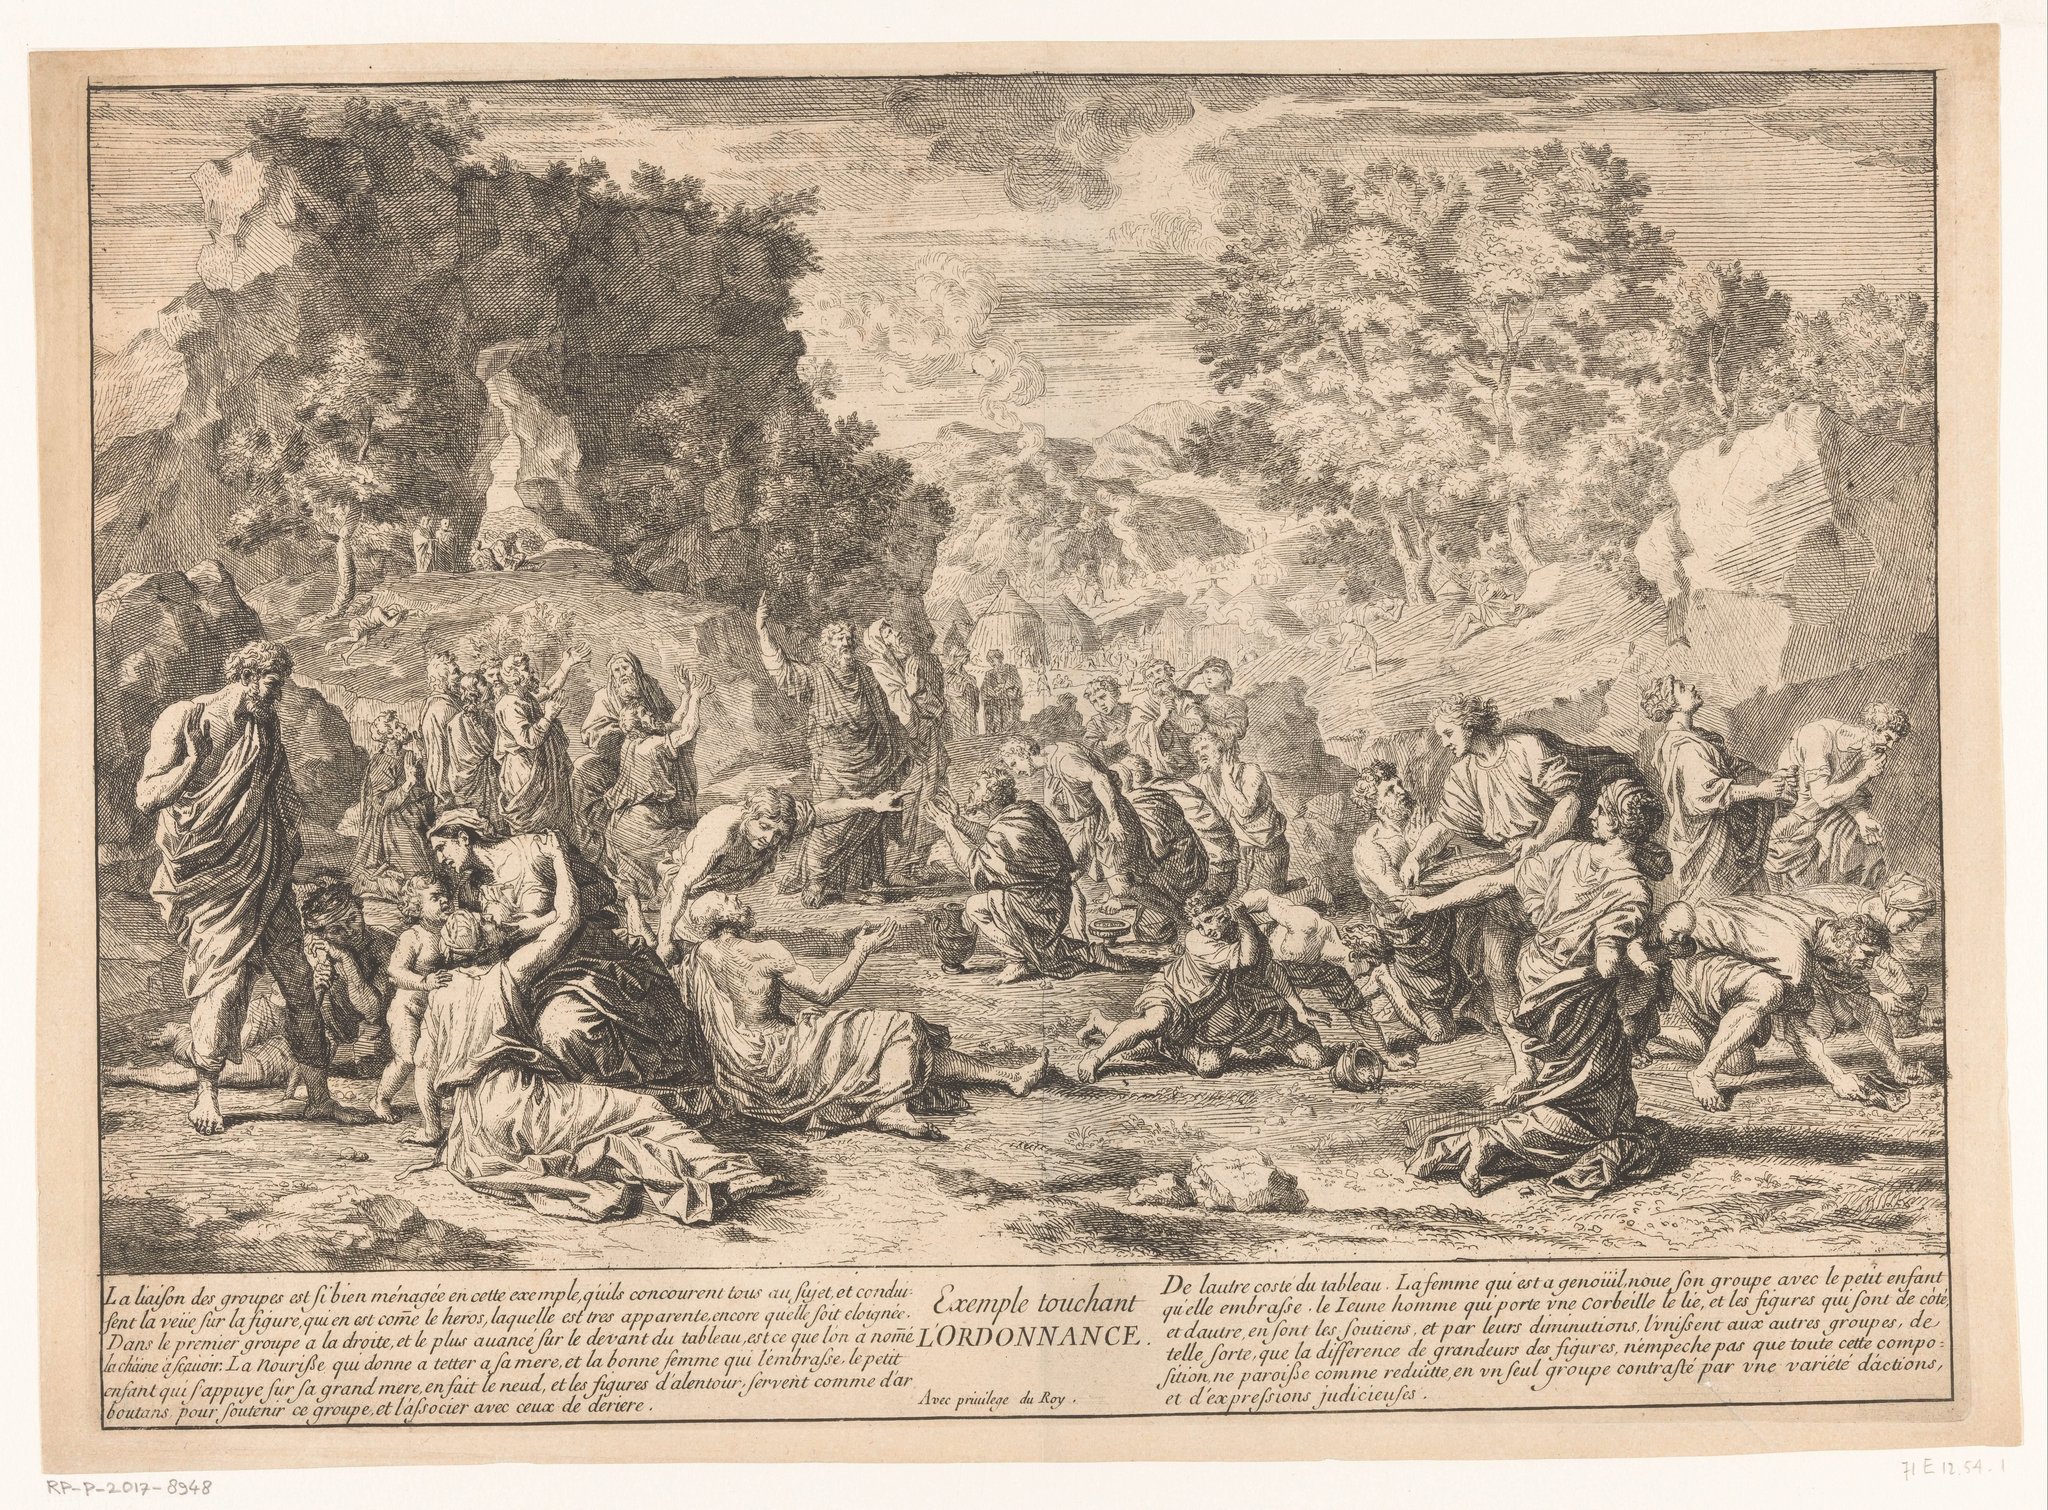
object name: print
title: Verzamelen van het manna in de woestijn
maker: henri testelin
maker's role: print maker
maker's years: 1616-1695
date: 1639-1695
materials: paper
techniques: etching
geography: france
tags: the gathering of manna (in baskets and pots)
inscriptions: collector's mark: Lugt 2228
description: Het schilderij geschilderd door Poussin in 1639 bevindt zich in de collectie van het Musée du Louvre te Parijs, inv.nr. 7275.